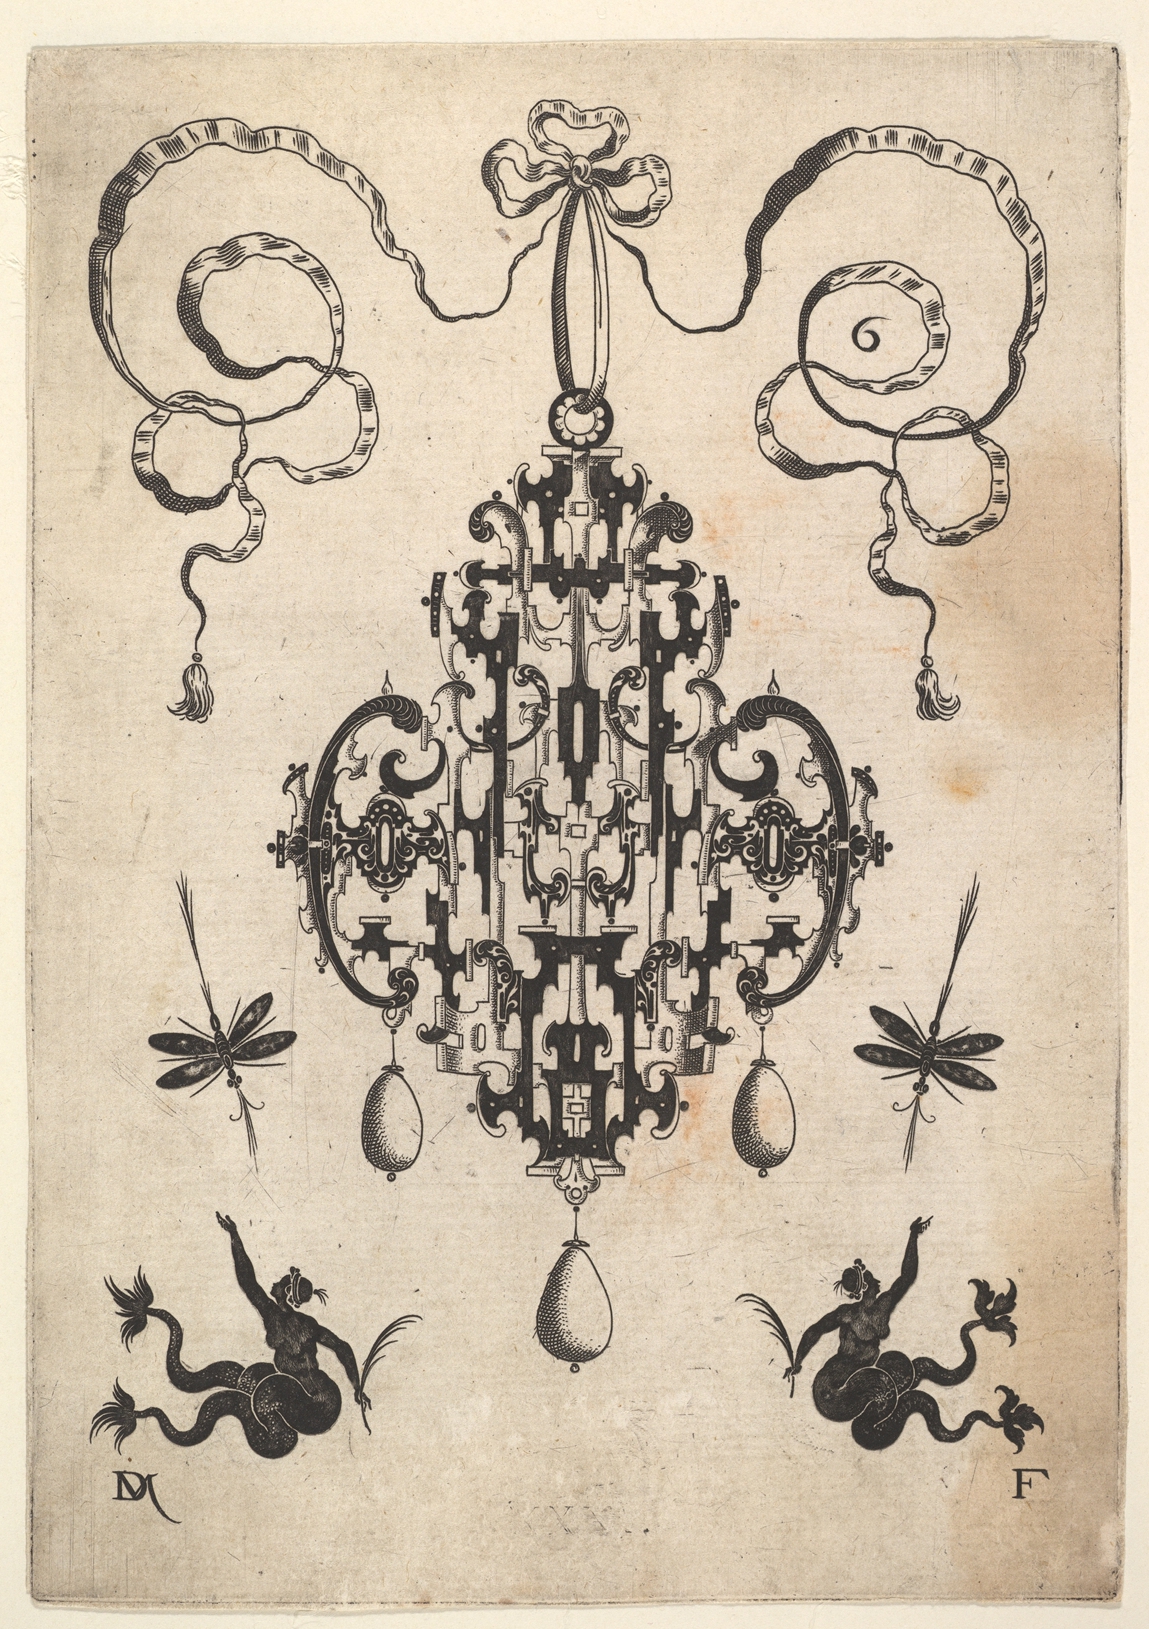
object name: print collection ornament architecture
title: Design for a Pendant Combined with Sirens and Dragonflies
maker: daniel mignot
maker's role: artist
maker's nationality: french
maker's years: 1593-1616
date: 1616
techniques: embroidery, engraving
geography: germany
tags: pendants,dragonflies